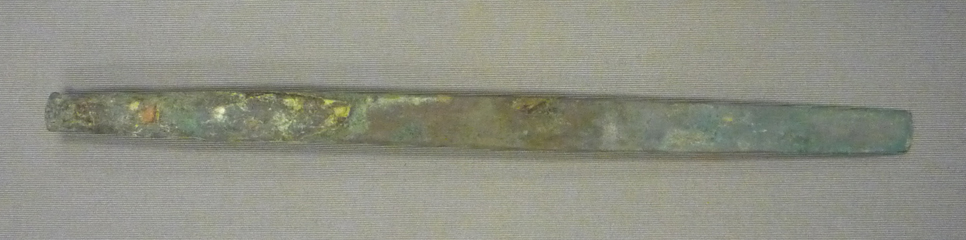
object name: chisel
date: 1479-1458 BCE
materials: bronze, copper alloy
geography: egypt